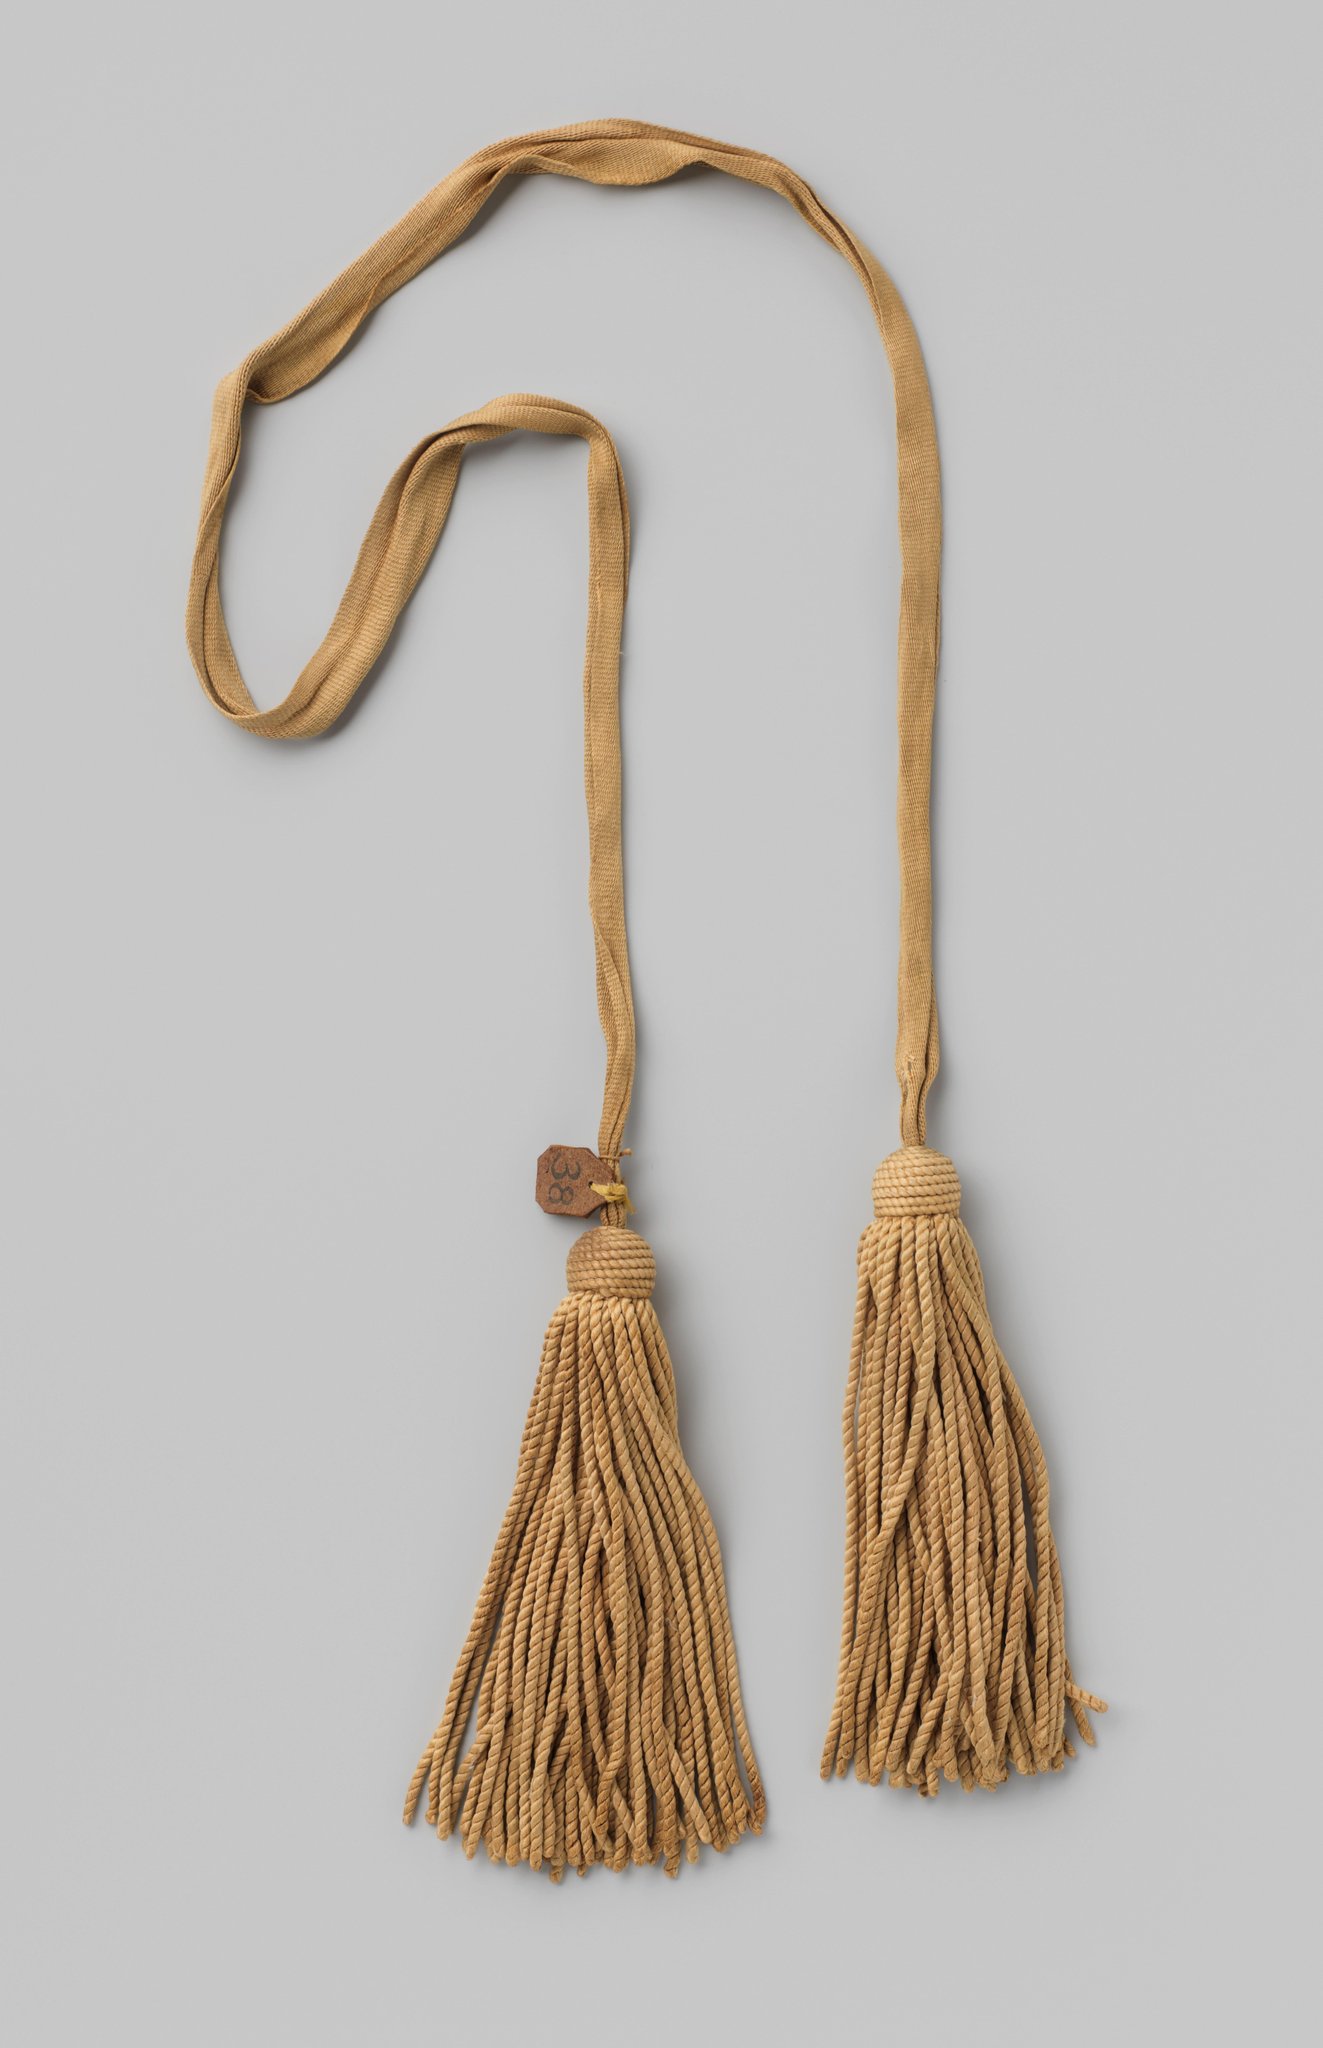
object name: sash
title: Sjerp van oranje zijde gedragen door Van Tol, in 1830/32 kapitein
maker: Anonymous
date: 1815-1830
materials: silk, wood, wool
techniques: knotting, stitching, turning, weave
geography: netherlands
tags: netherlands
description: Sjerp van oranje (verfletste) koordzijde, in techniek van "Egyptisch vlechtwerk" in het midden is het vlechtwerk bij elkaar gevlochten. Aan beide zijdes is een kwast, van koordzijde bevestigd, waaraan lange franjes zijn bevestigd, door de kwasten heen is de sjerp getrokken, en aan de onderzijdes met knopen bevestigd. De knopen zijn met stiksels verstevigd.